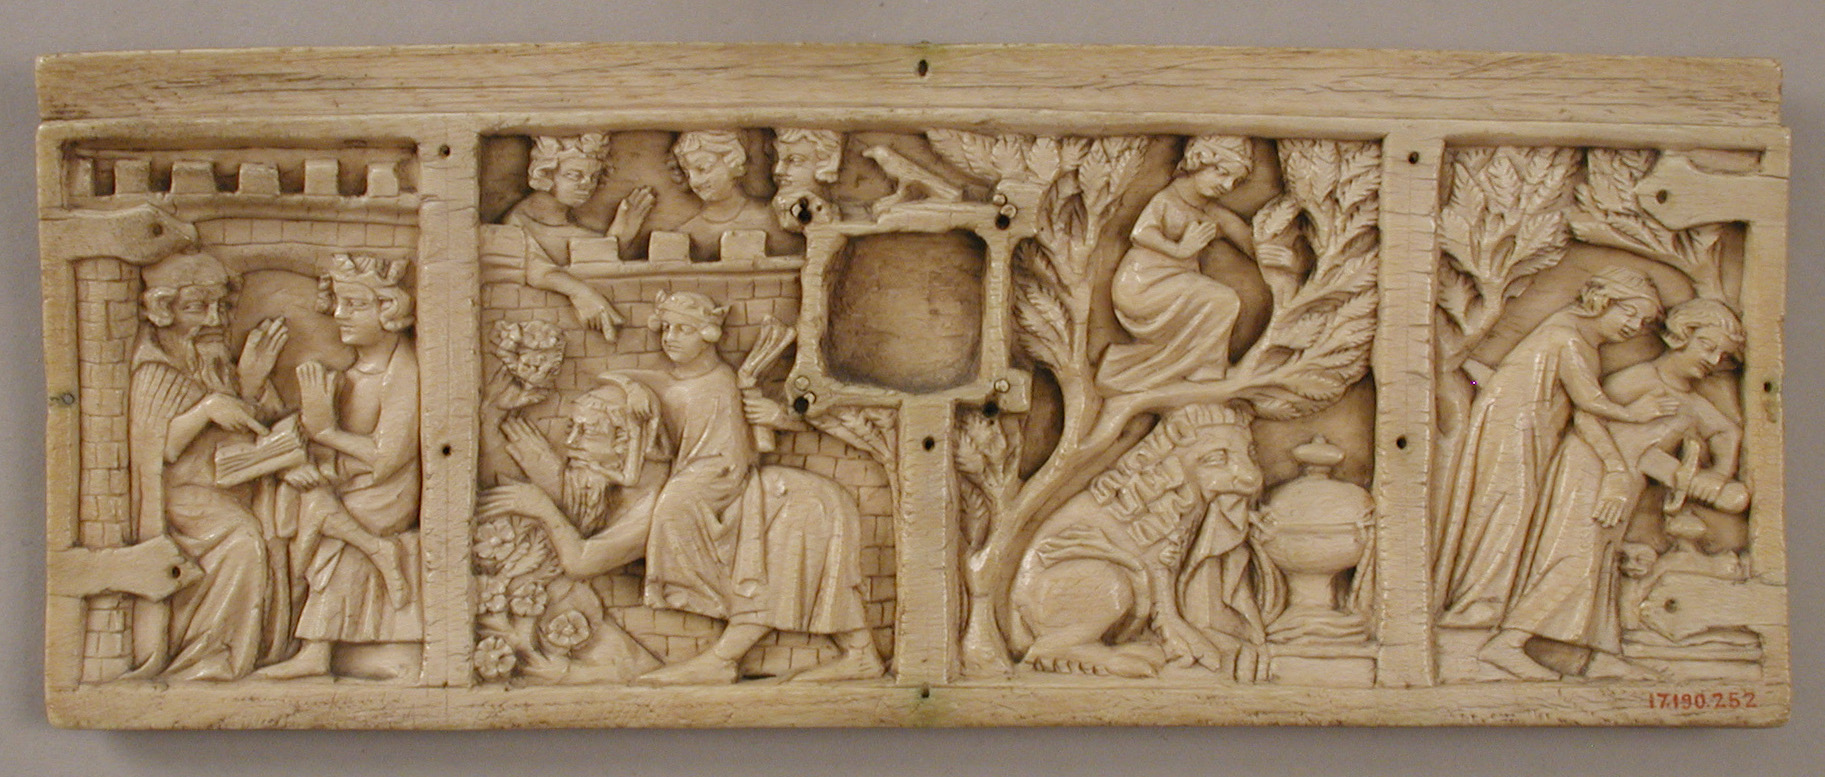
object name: panel, from a box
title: Panel from a Box with Scenes from Romance Literature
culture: french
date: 1301-1400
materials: ivory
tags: men,women